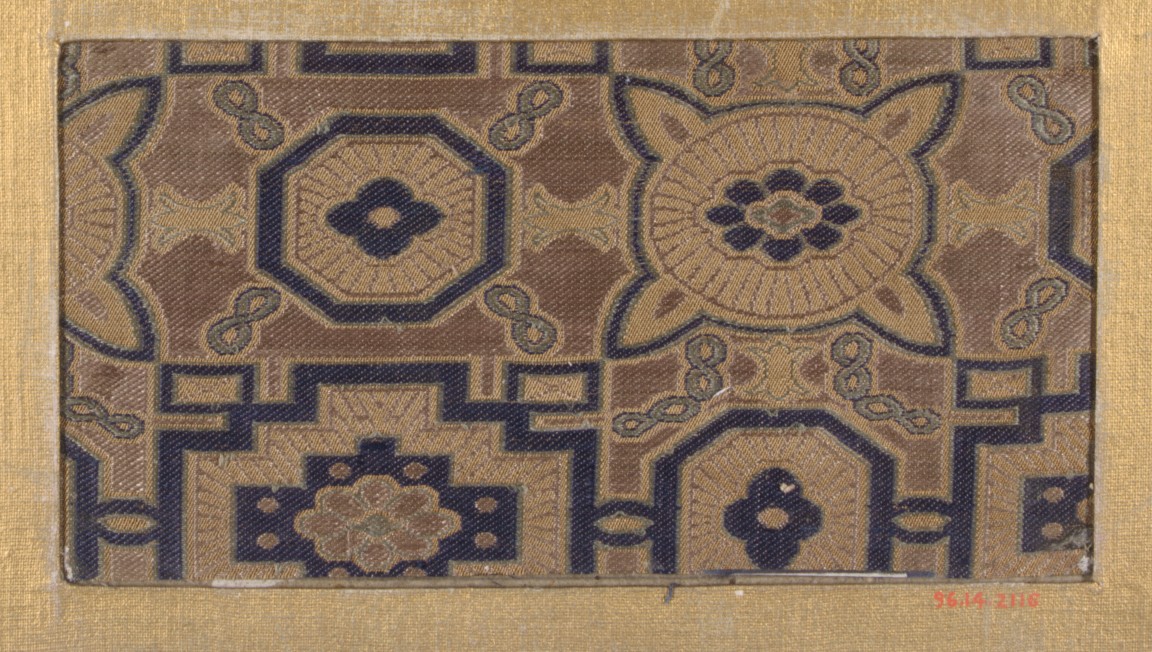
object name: piece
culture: japanese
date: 1701-1900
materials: silk